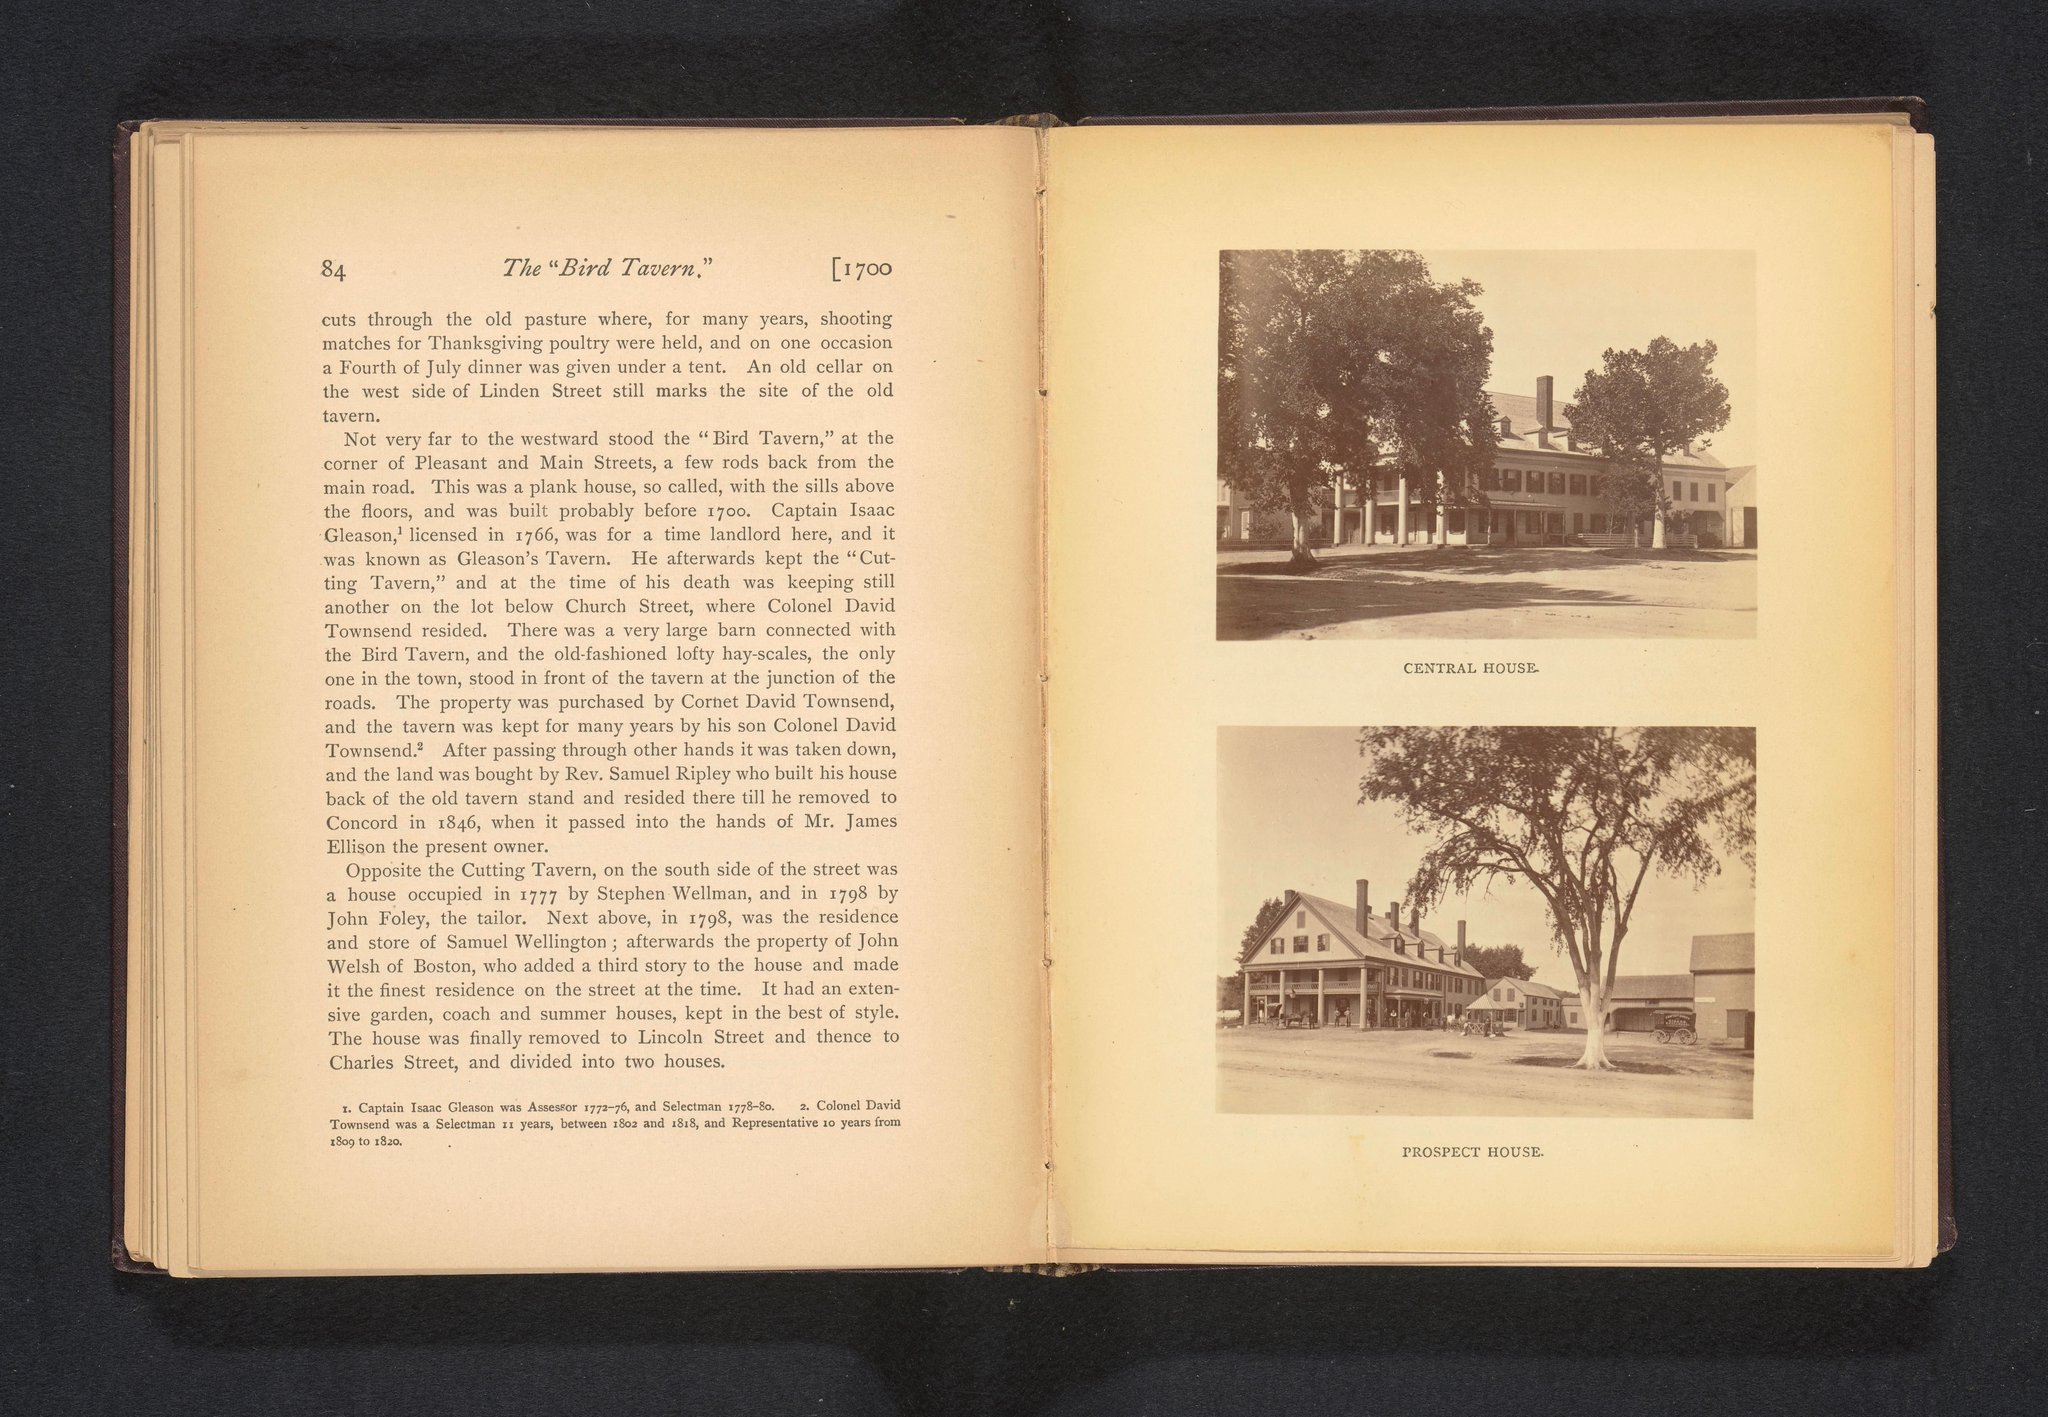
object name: photograph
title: Gezicht op Central House in Waltham, Massachusetts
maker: thomas r. lewis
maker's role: publisher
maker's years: 1845-1901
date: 1874-1879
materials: photographic support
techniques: albumen print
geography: waltham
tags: civic architecture; edifices; dwellings